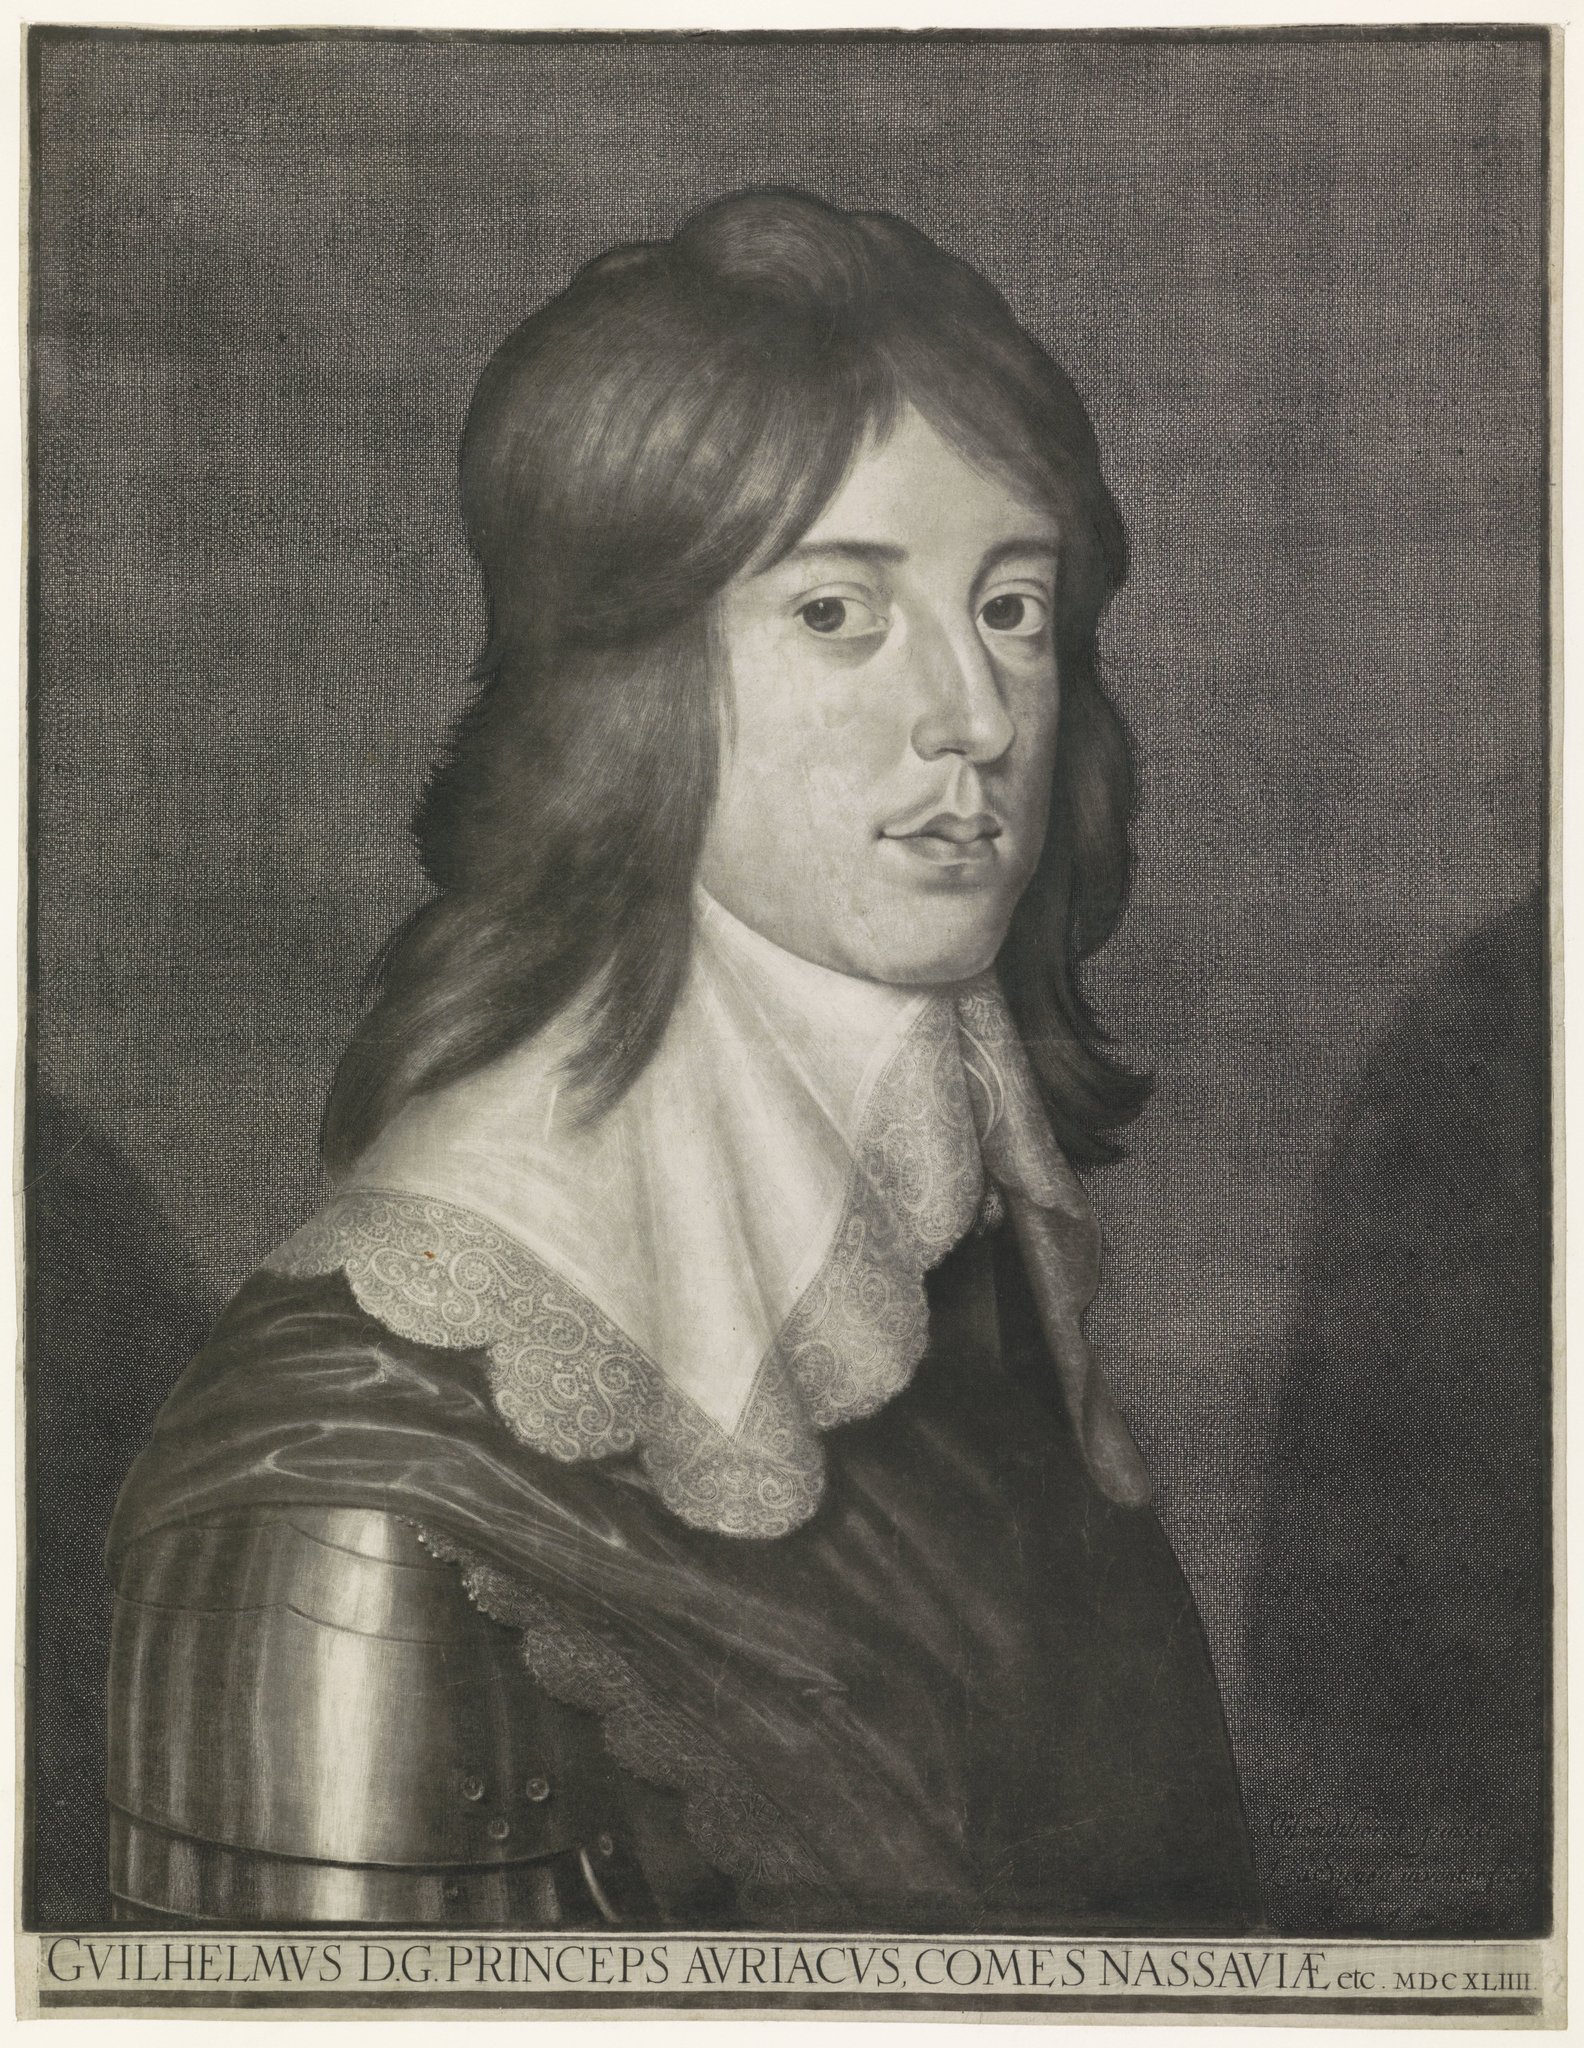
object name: print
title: Portret van Willem II, prins van Oranje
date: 1644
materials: paper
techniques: engraving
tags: william ii (prince of orange)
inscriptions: collector's mark: Lugt 2228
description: Willem II, prins van Oranje, in wapenrusting met een kraag van kant.